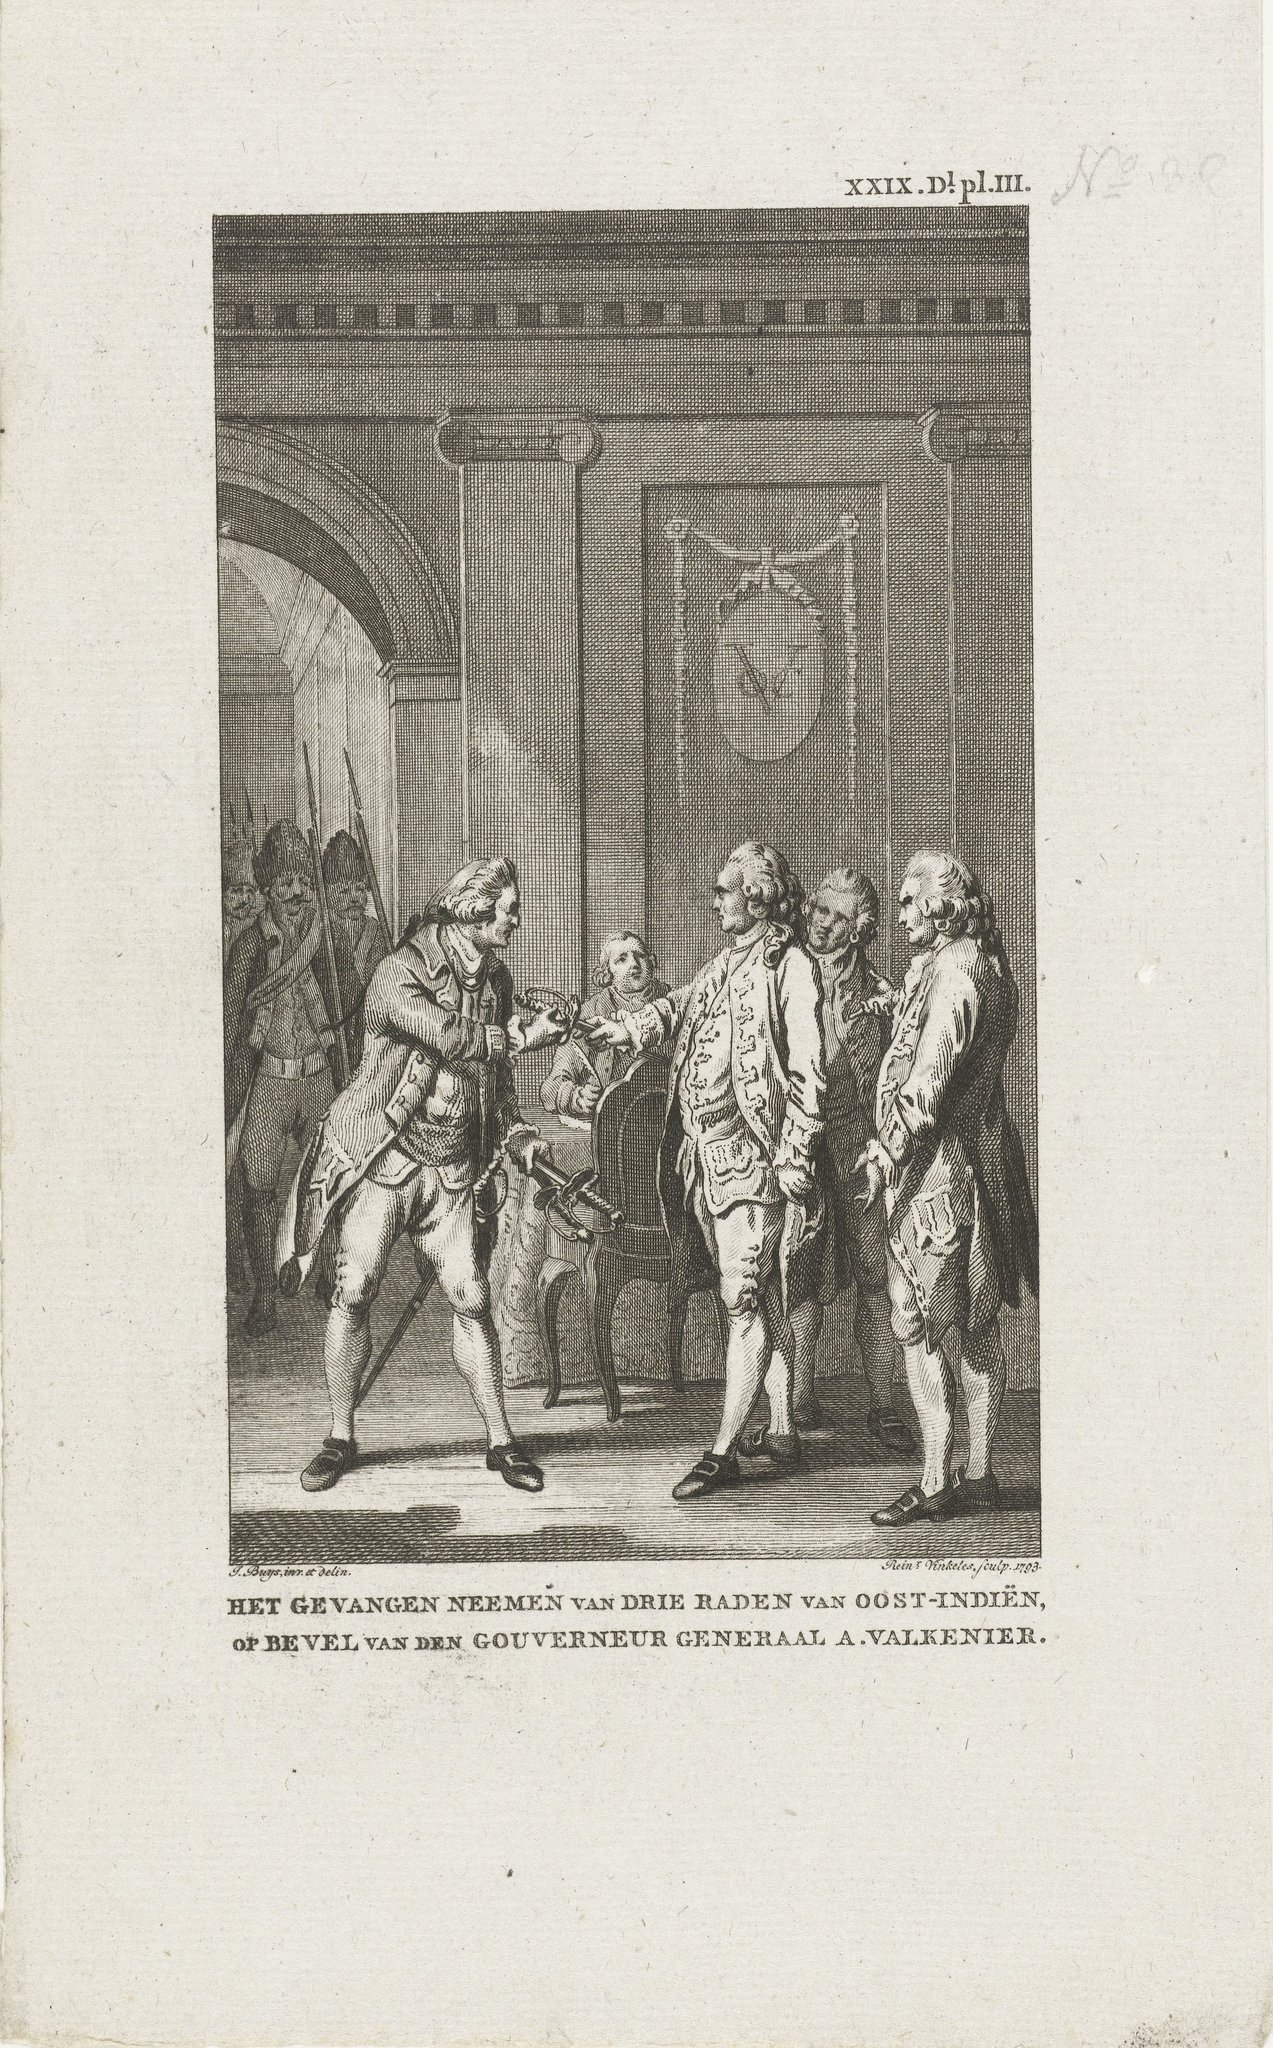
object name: print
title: Gevangenneming van drie raden van de VOC, 1740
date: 1793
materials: paper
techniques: engraving, etching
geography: northern netherlands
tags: arrest (of criminal), batavia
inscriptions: date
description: De gevangenneming van drie leden van de Raad van Indie in Batavia Gustaaf Willem van Imhoff, Isaac van Schinne en Elias Haese op bevel van de gouverneur-generaal Adriaan Valkenier, december 1740. Gemerkt rechtsboven: XXIX. Dl. pl. III.